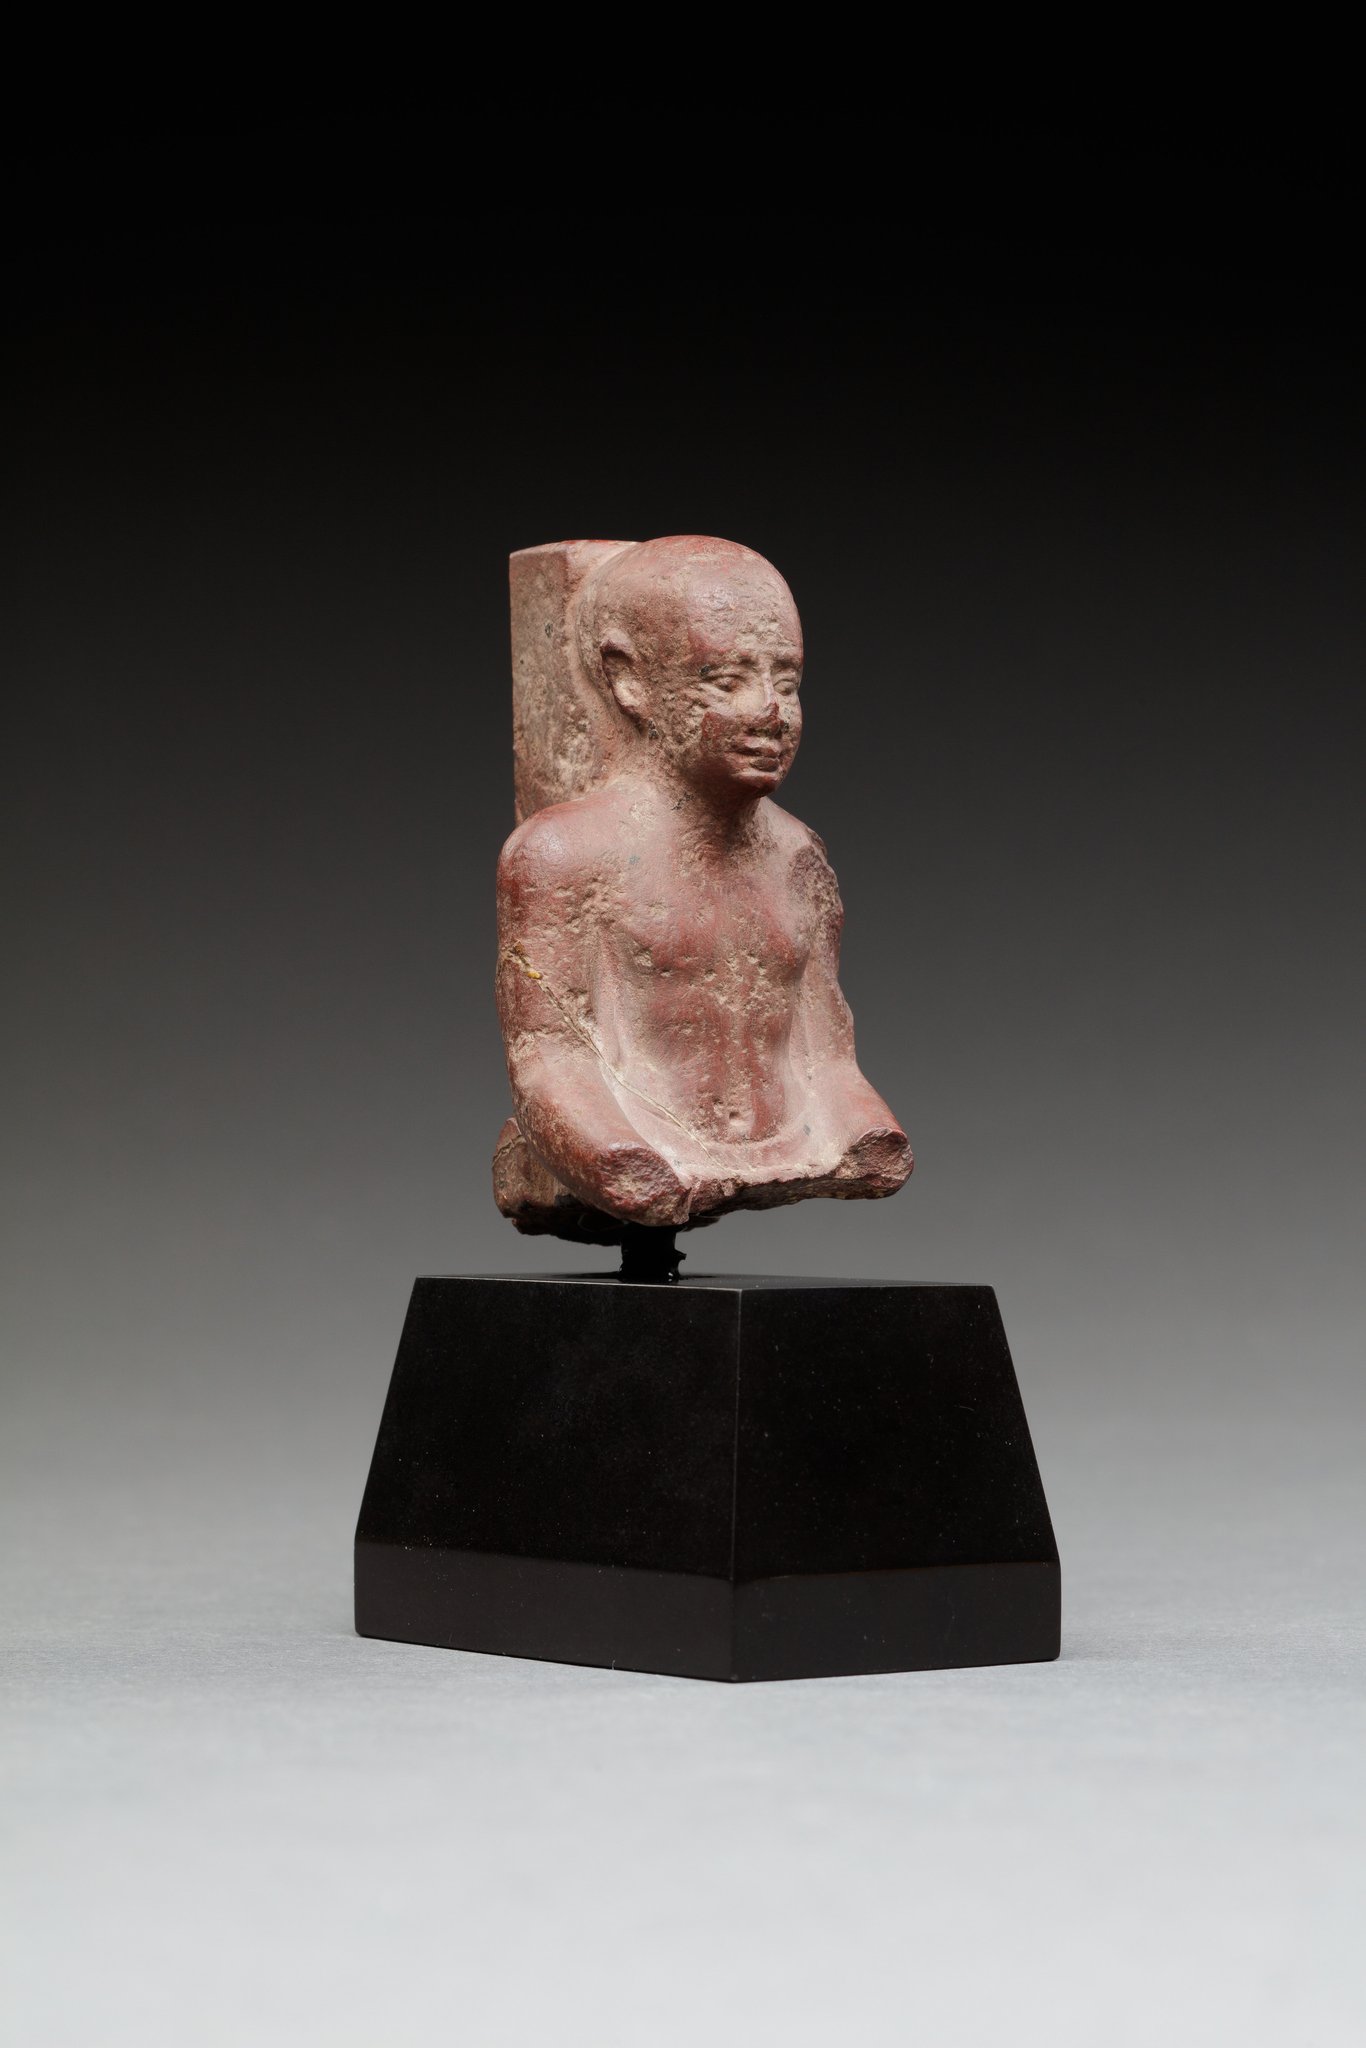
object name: imhotep, seated, pillar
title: Statuette of Imhotep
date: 400-200 BCE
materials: quartzite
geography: egypt